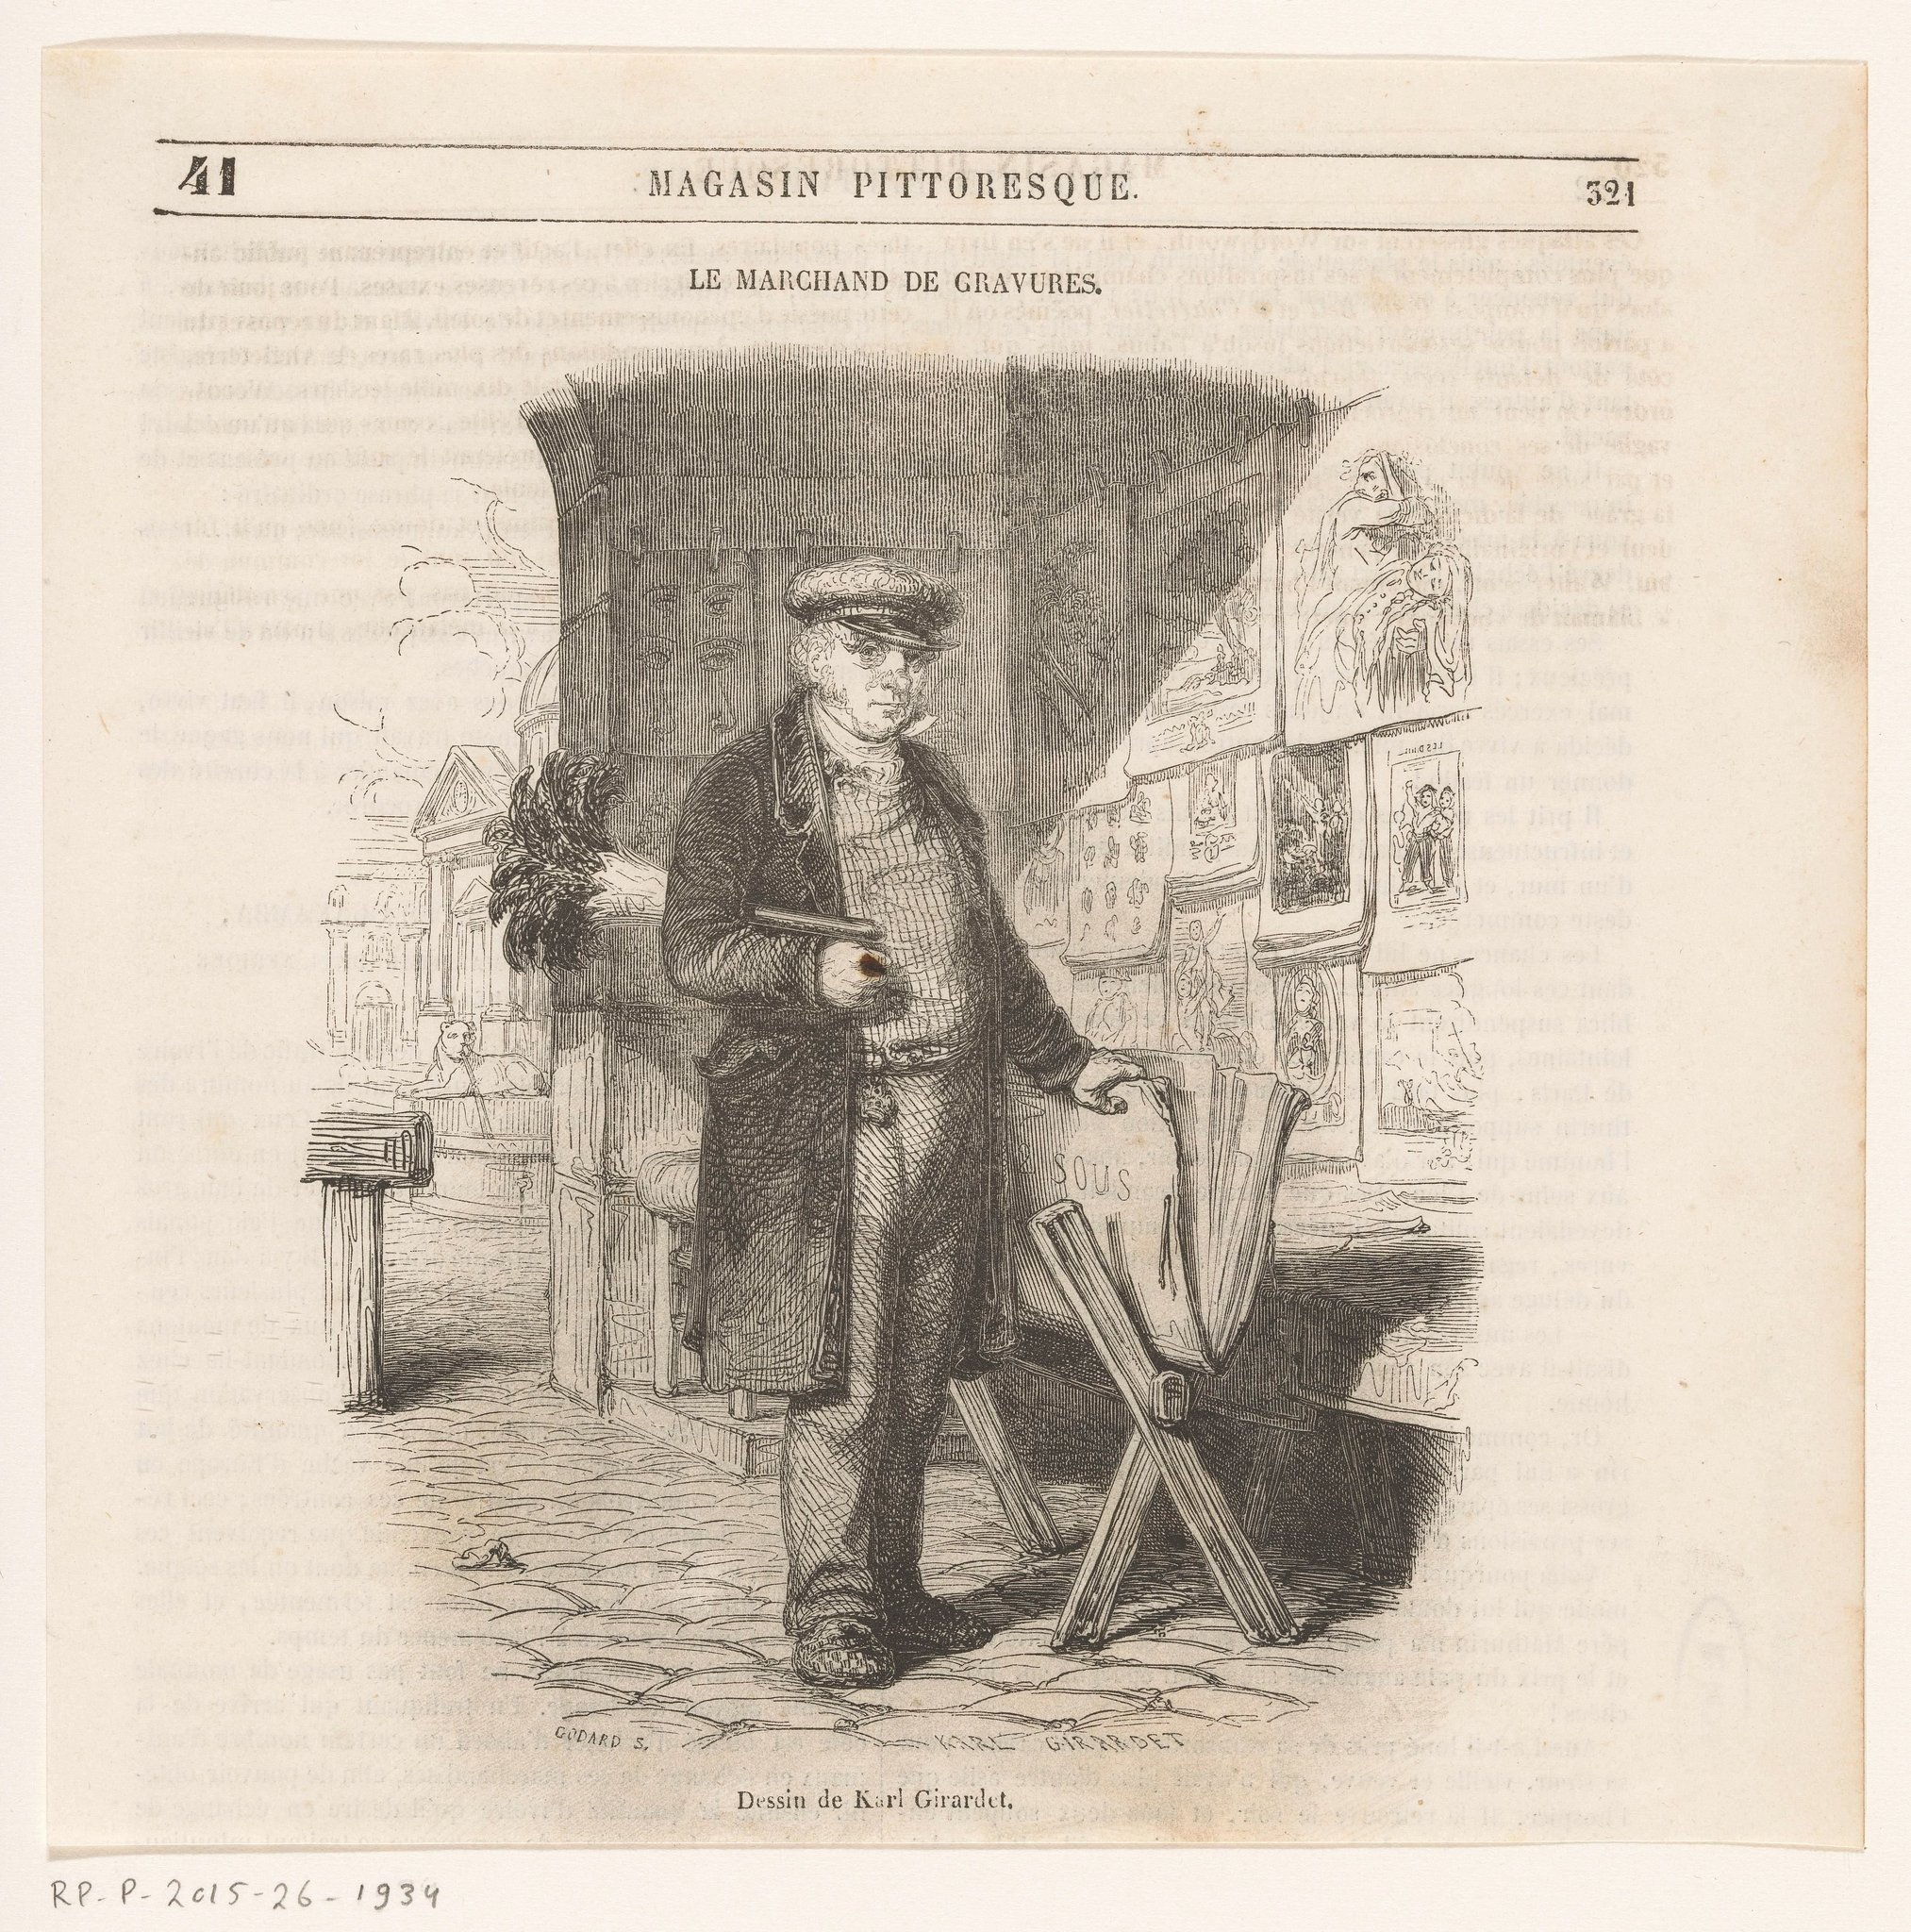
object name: print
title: Prenthandelaar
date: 1851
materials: paper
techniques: engraving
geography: alençon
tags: print, e.g.: engraving, etching, lithograph, art dealer (+ graphic arts), street-trader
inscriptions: collector's mark: Lugt 2228, collector's mark: Lugt 4780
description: Een prenthandelaar staat voor zijn kraam, een plumeau onder zijn arm geklemd. Tekst op verso. Linksboven genummerd: 41; rechtsboven: 321.